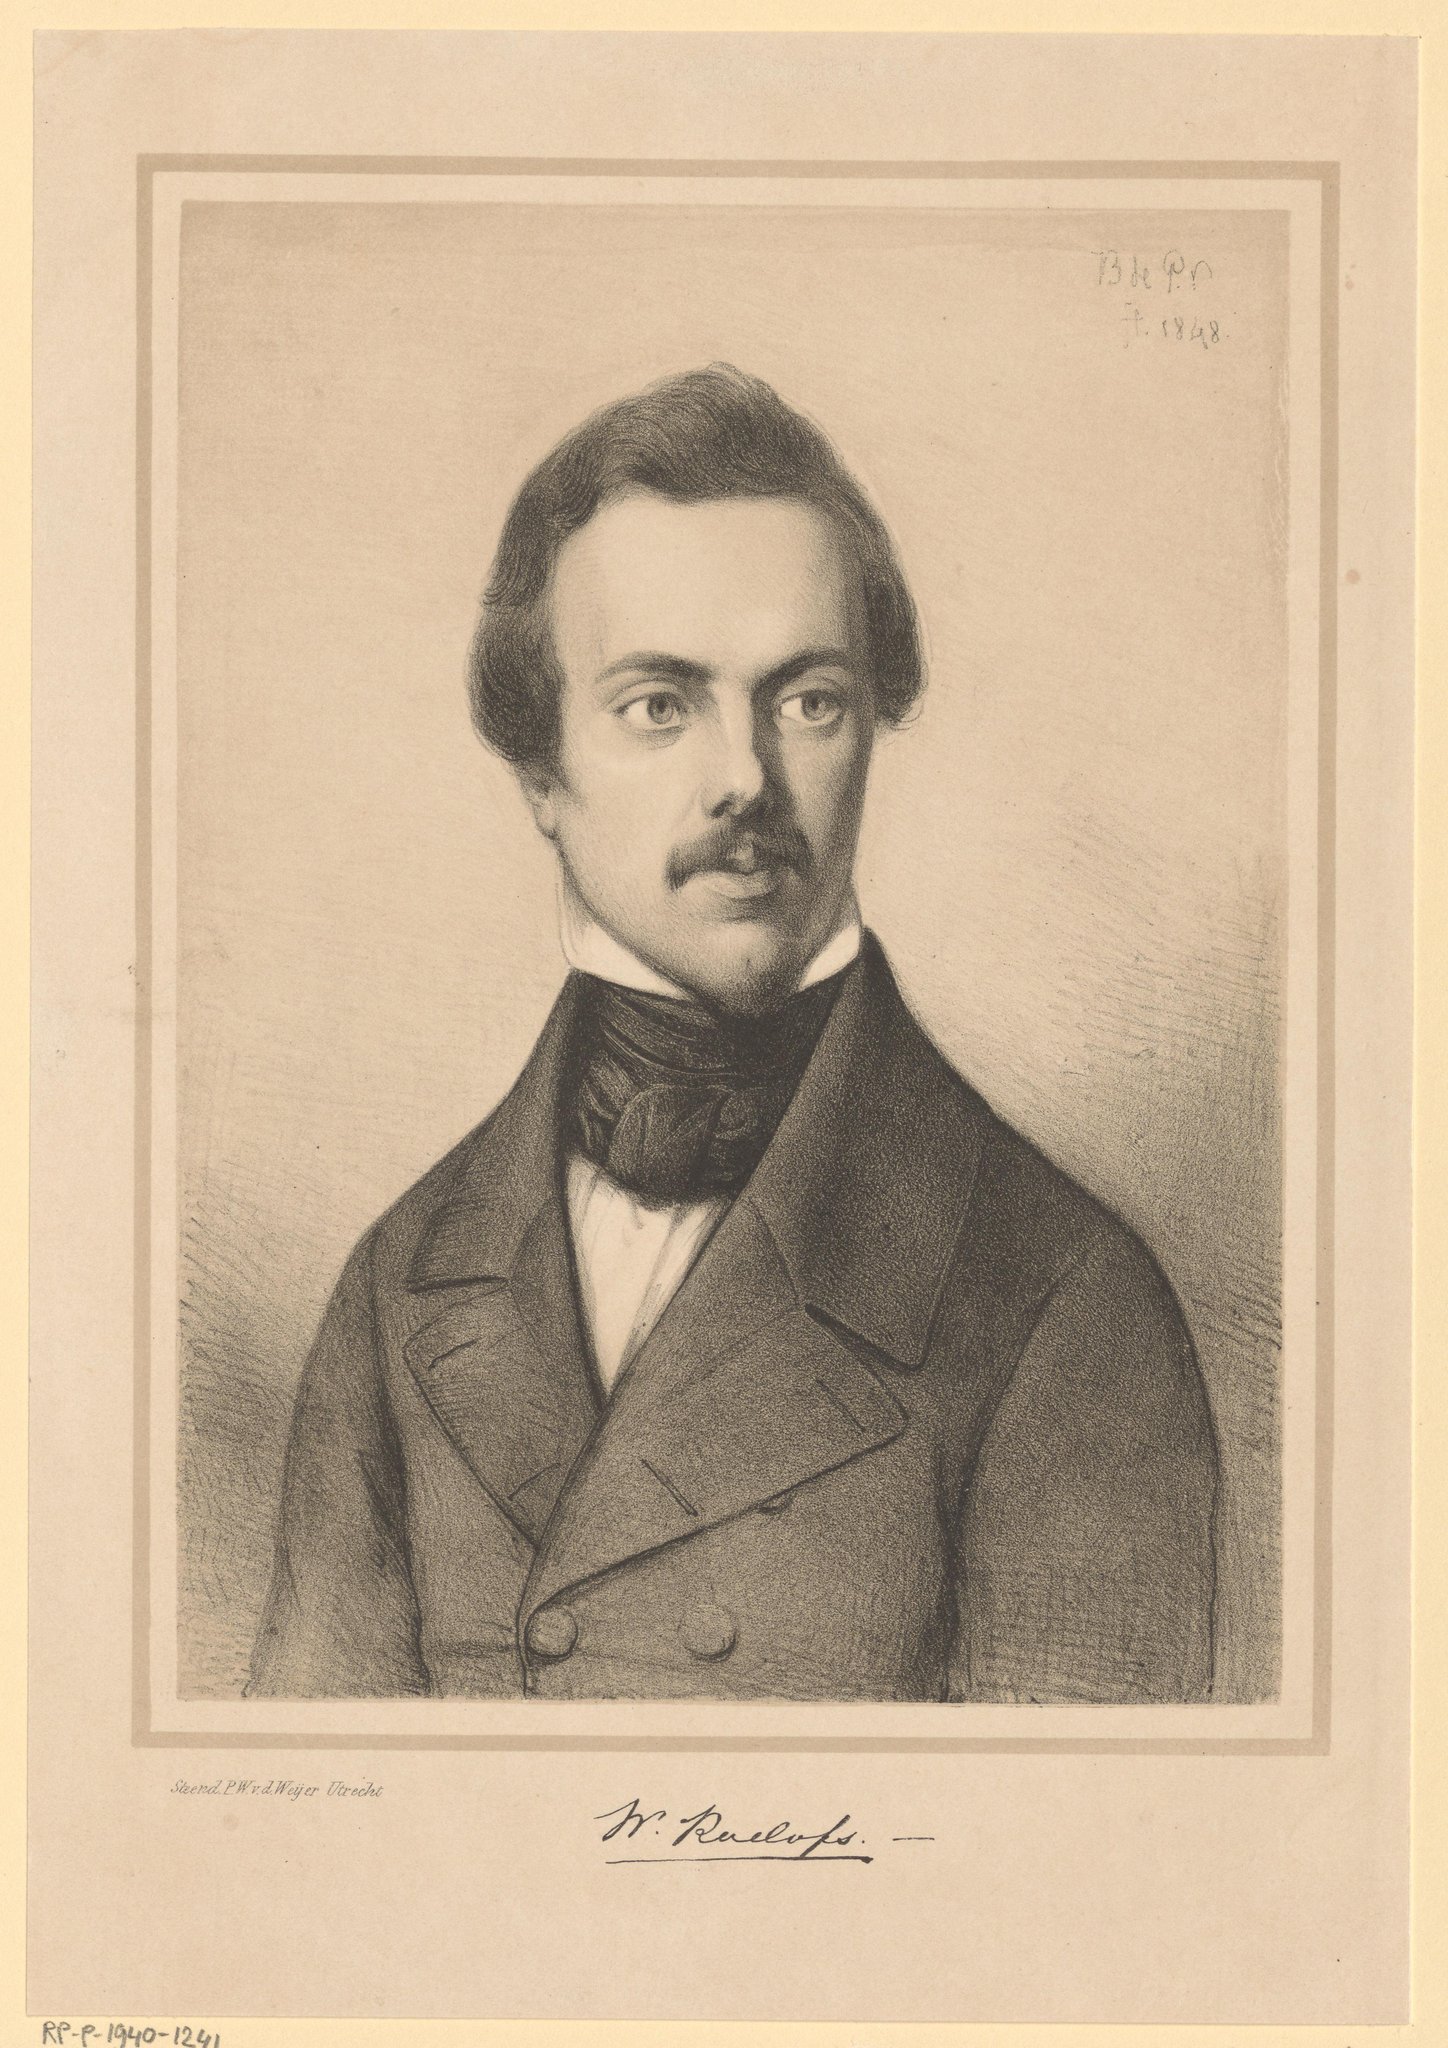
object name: print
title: Portret van Willem Roelofs I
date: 1848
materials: paper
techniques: lithograph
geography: utrecht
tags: amsterdam, painter, print maker, draughtsman, willem roelofs (i), historical persons, portrait, self-portrait of painter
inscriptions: collector's mark: Lugt 2760, collector's mark: Lugt 2228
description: Onder het portret een facsimile van de handtekening van de geportretteerde.